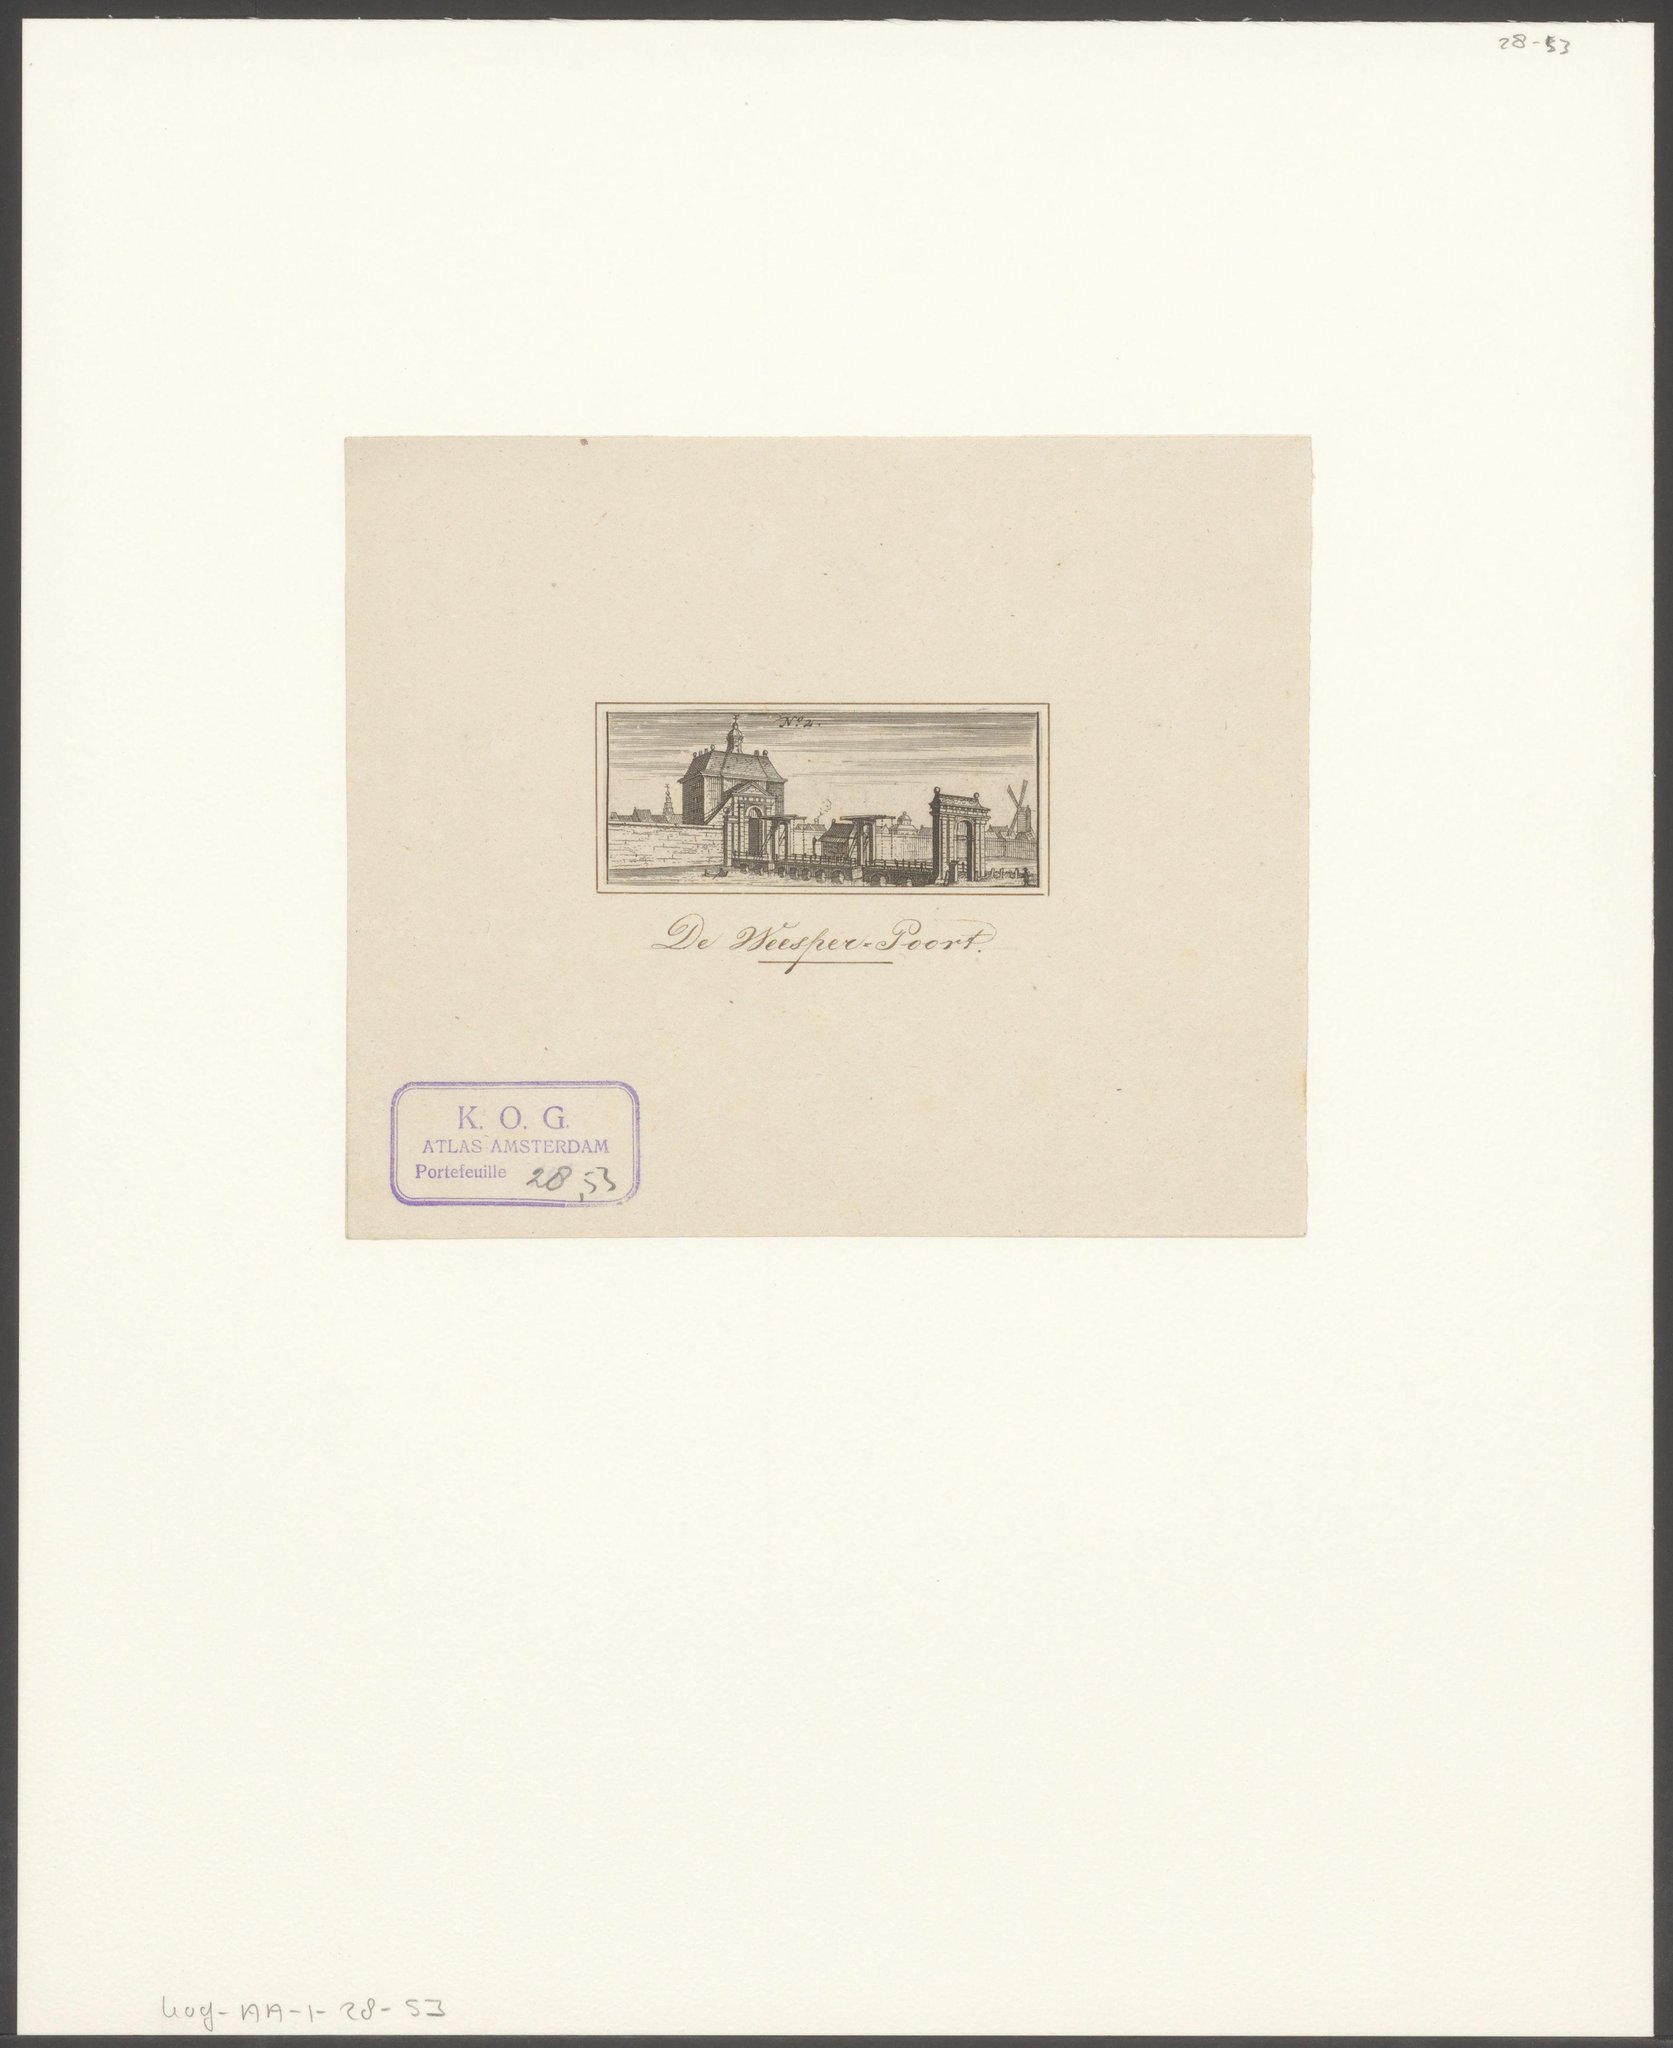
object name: print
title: Gezicht op de Weesperpoort te Amsterdam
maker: jan lamsvelt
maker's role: print maker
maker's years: 1674-1743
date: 1741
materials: paper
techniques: etching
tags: city-gate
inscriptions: collector's mark: Lugt 1641b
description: Prent waarschijnlijk uit: Gebouwen, gezichten, en oudheden Der Stad Amsterdam. Haarlem: Johannes Marshoorn, 1741. Prent eerder gebruikt in: Leuve, Roeland van. 's Waerelds koopslot of De Amsteldamse beurs. Amsterdam: Jacobus Verheyden (I), 1723.